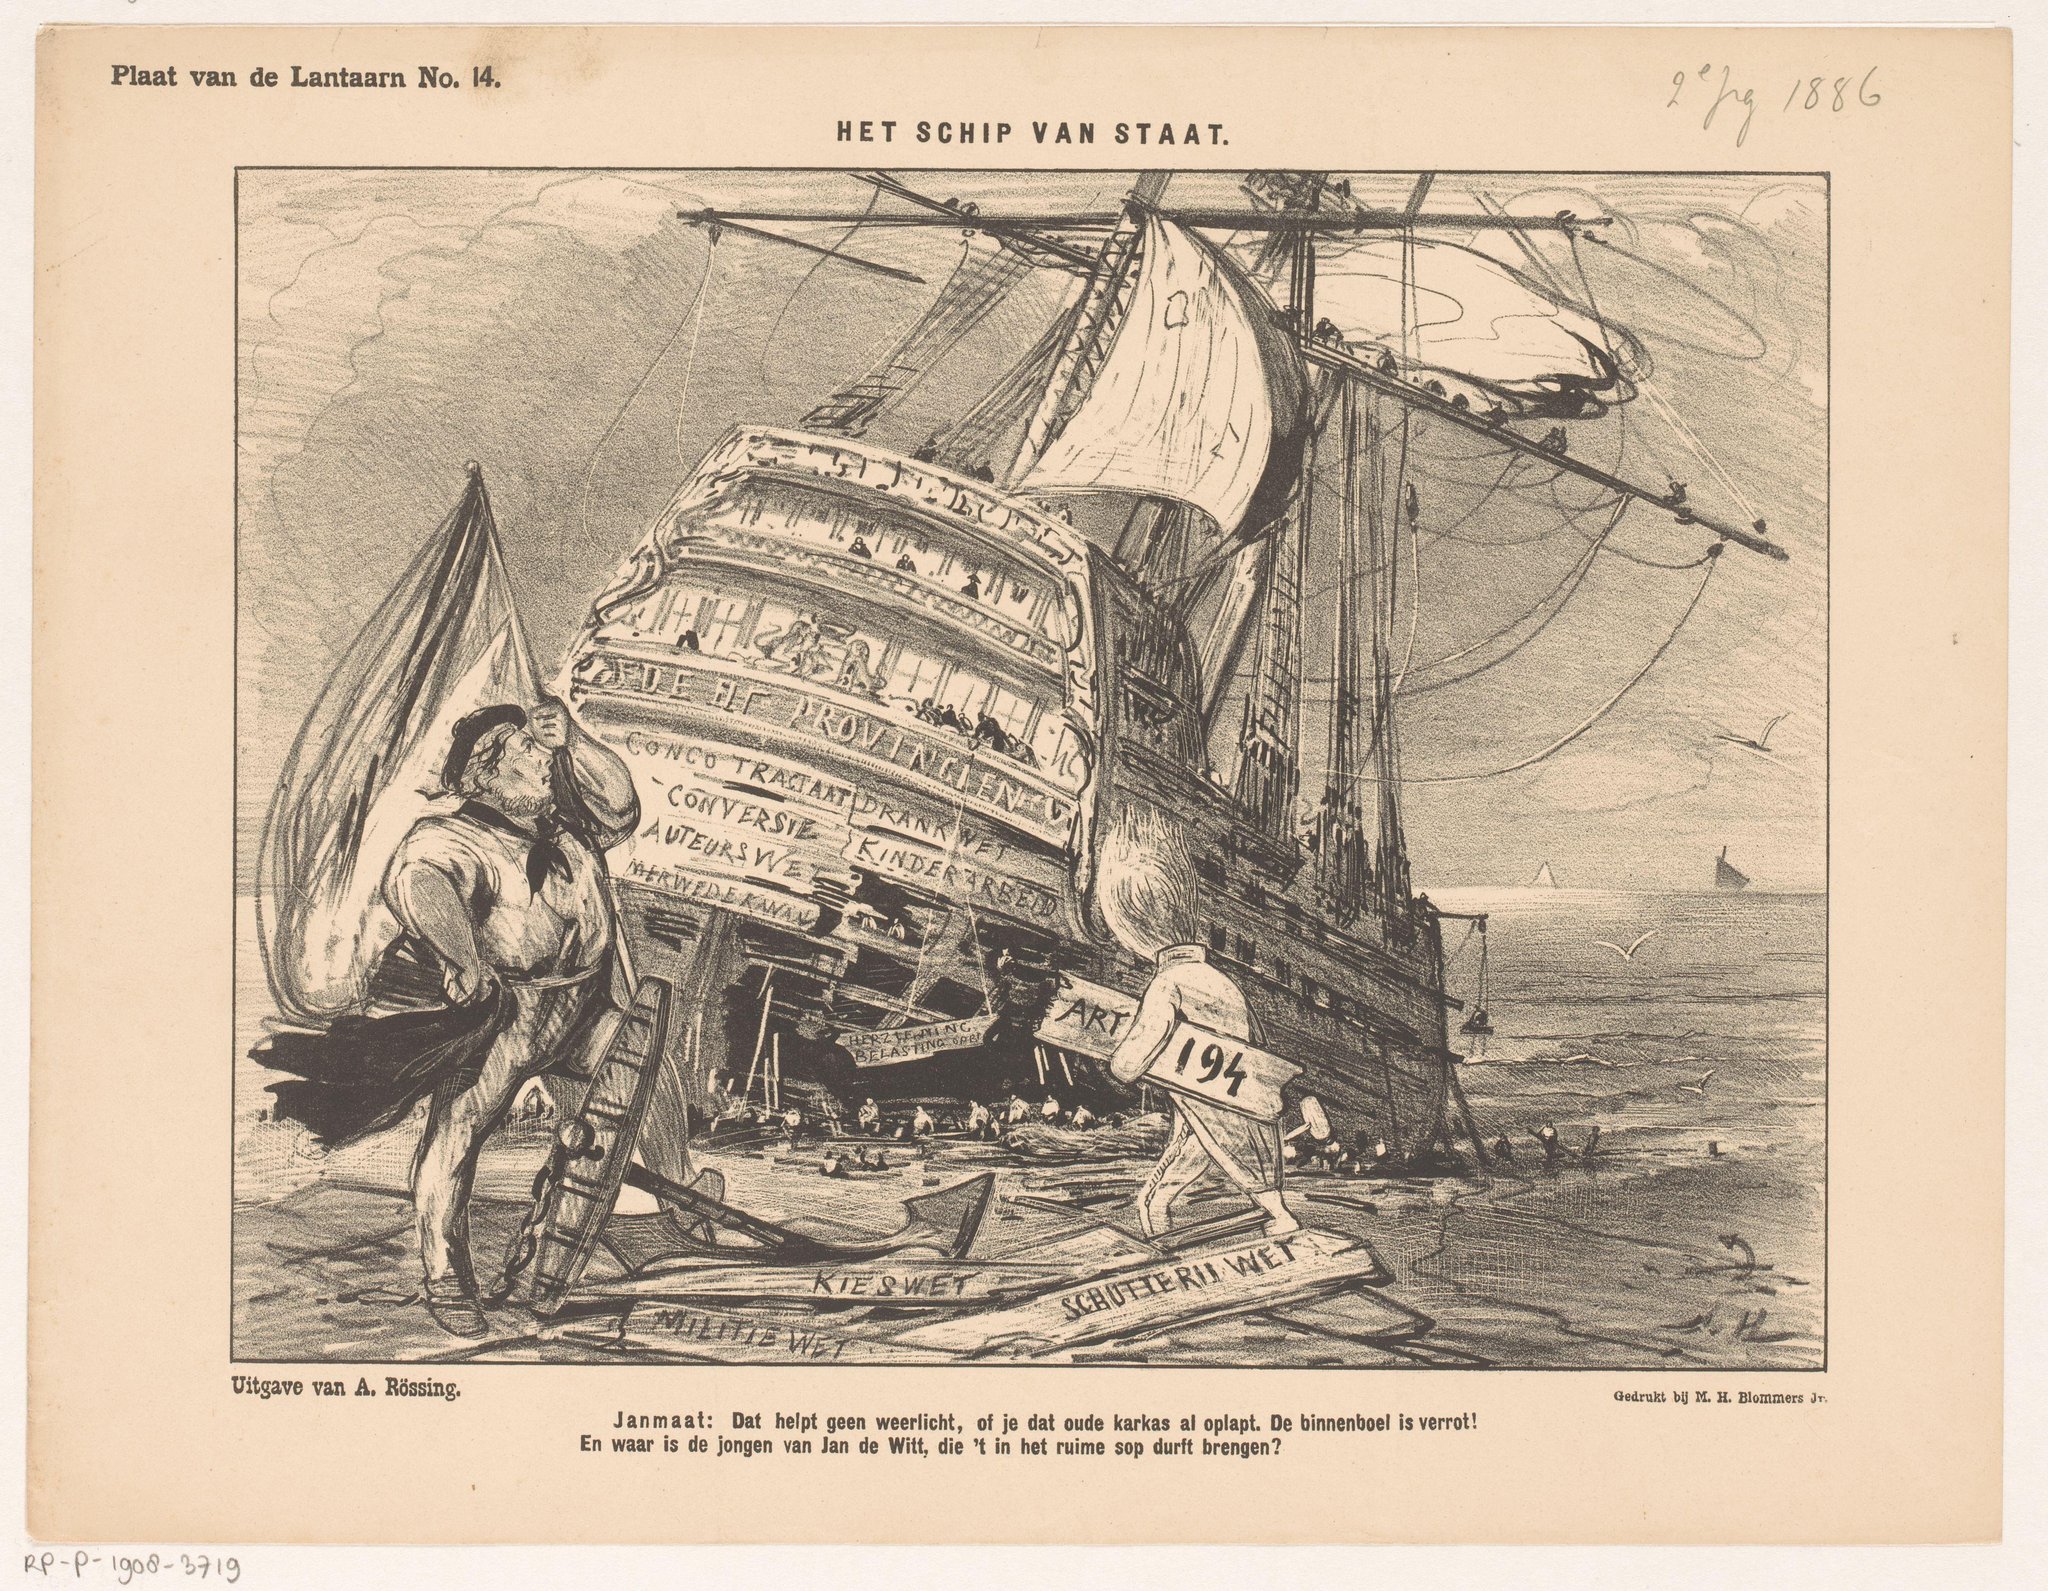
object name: print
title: Spotprent over de grondwetsherziening in 1886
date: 1886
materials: paper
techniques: lithograph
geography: the hague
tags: sailor, repairing, caulking, careening (~ ship), political caricatures and satires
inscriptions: collector's mark: Lugt 2228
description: Het schip van de staat ligt gehavend op het strand tussen wrakstukken van actuele kwesties. Aan de kant staat een matroos. Volgens hem is het schip van binnen verrot en gaat een opknapbeurt geen goed doen. Hiermee verwijst hij naar de politieke onrust tijdens het kabinet Heemskerk en diens mislukte pogingen om de grondwetsherzieningen te realiseren. Deze prent werd uitgegeven bij De Lantaarn.